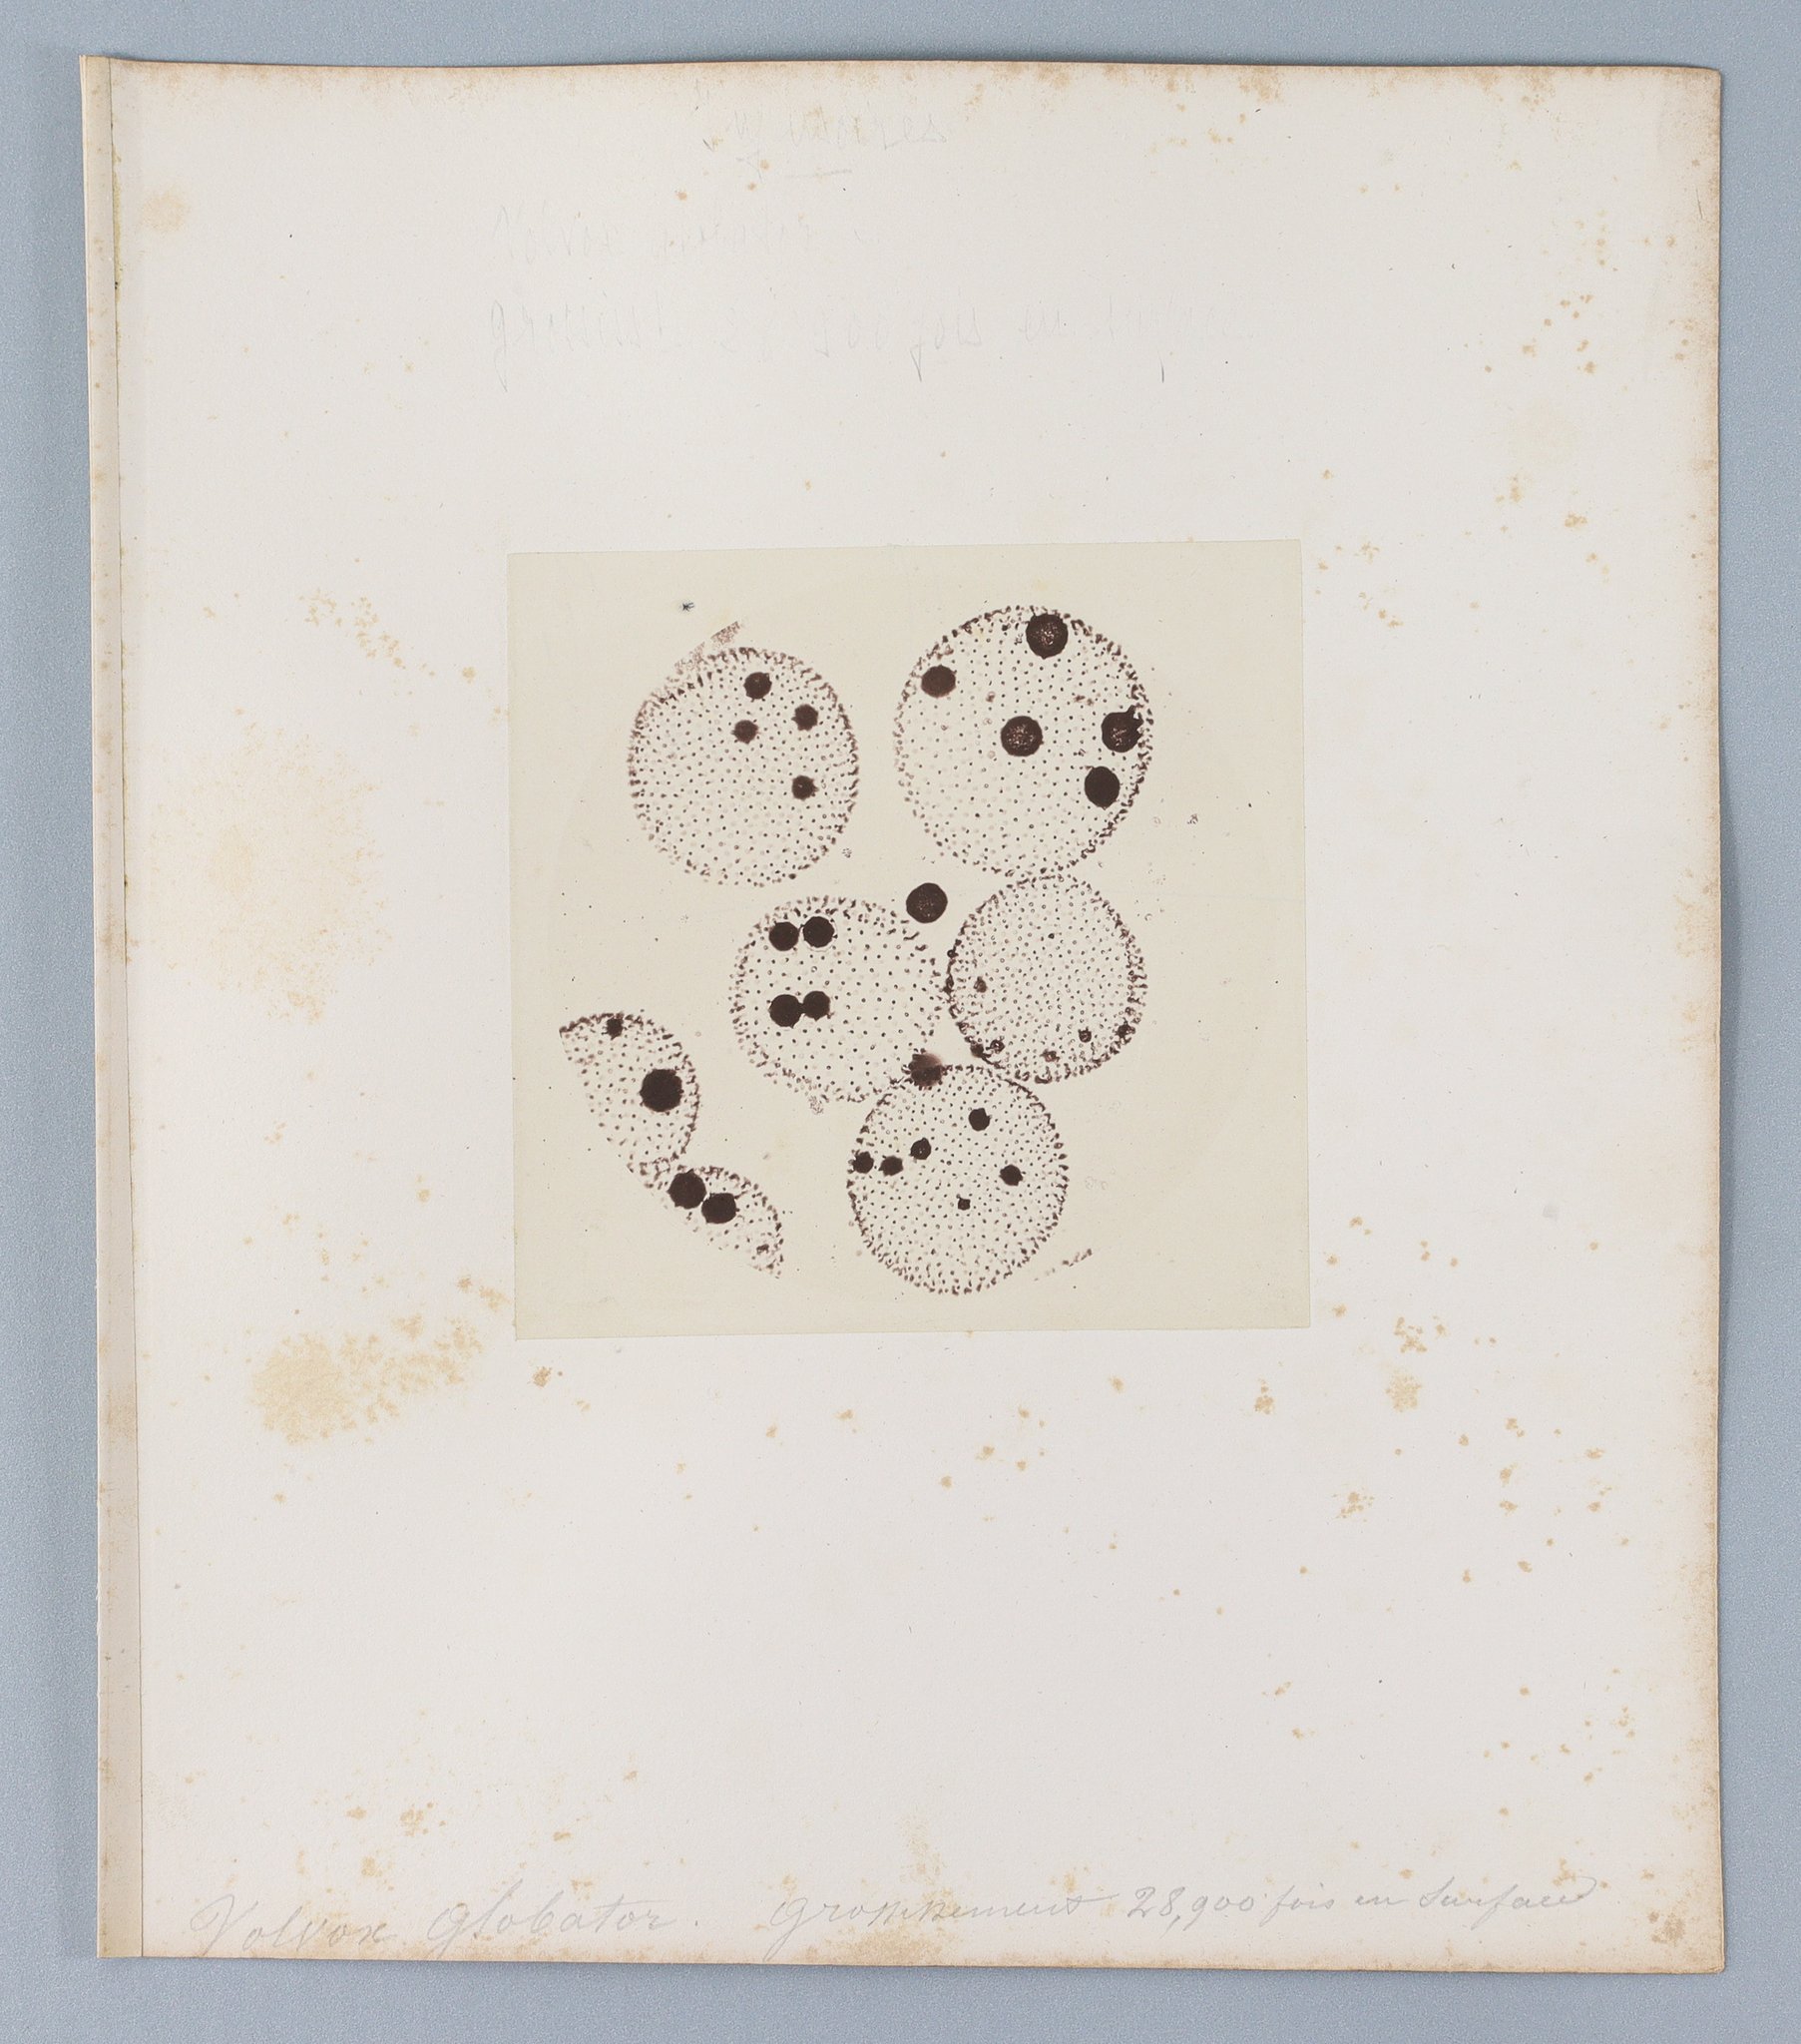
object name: photograph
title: [Untitled]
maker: auguste-adolphe bertsch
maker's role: artist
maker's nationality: french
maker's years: 1813-1871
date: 1853-1857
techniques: salted paper print